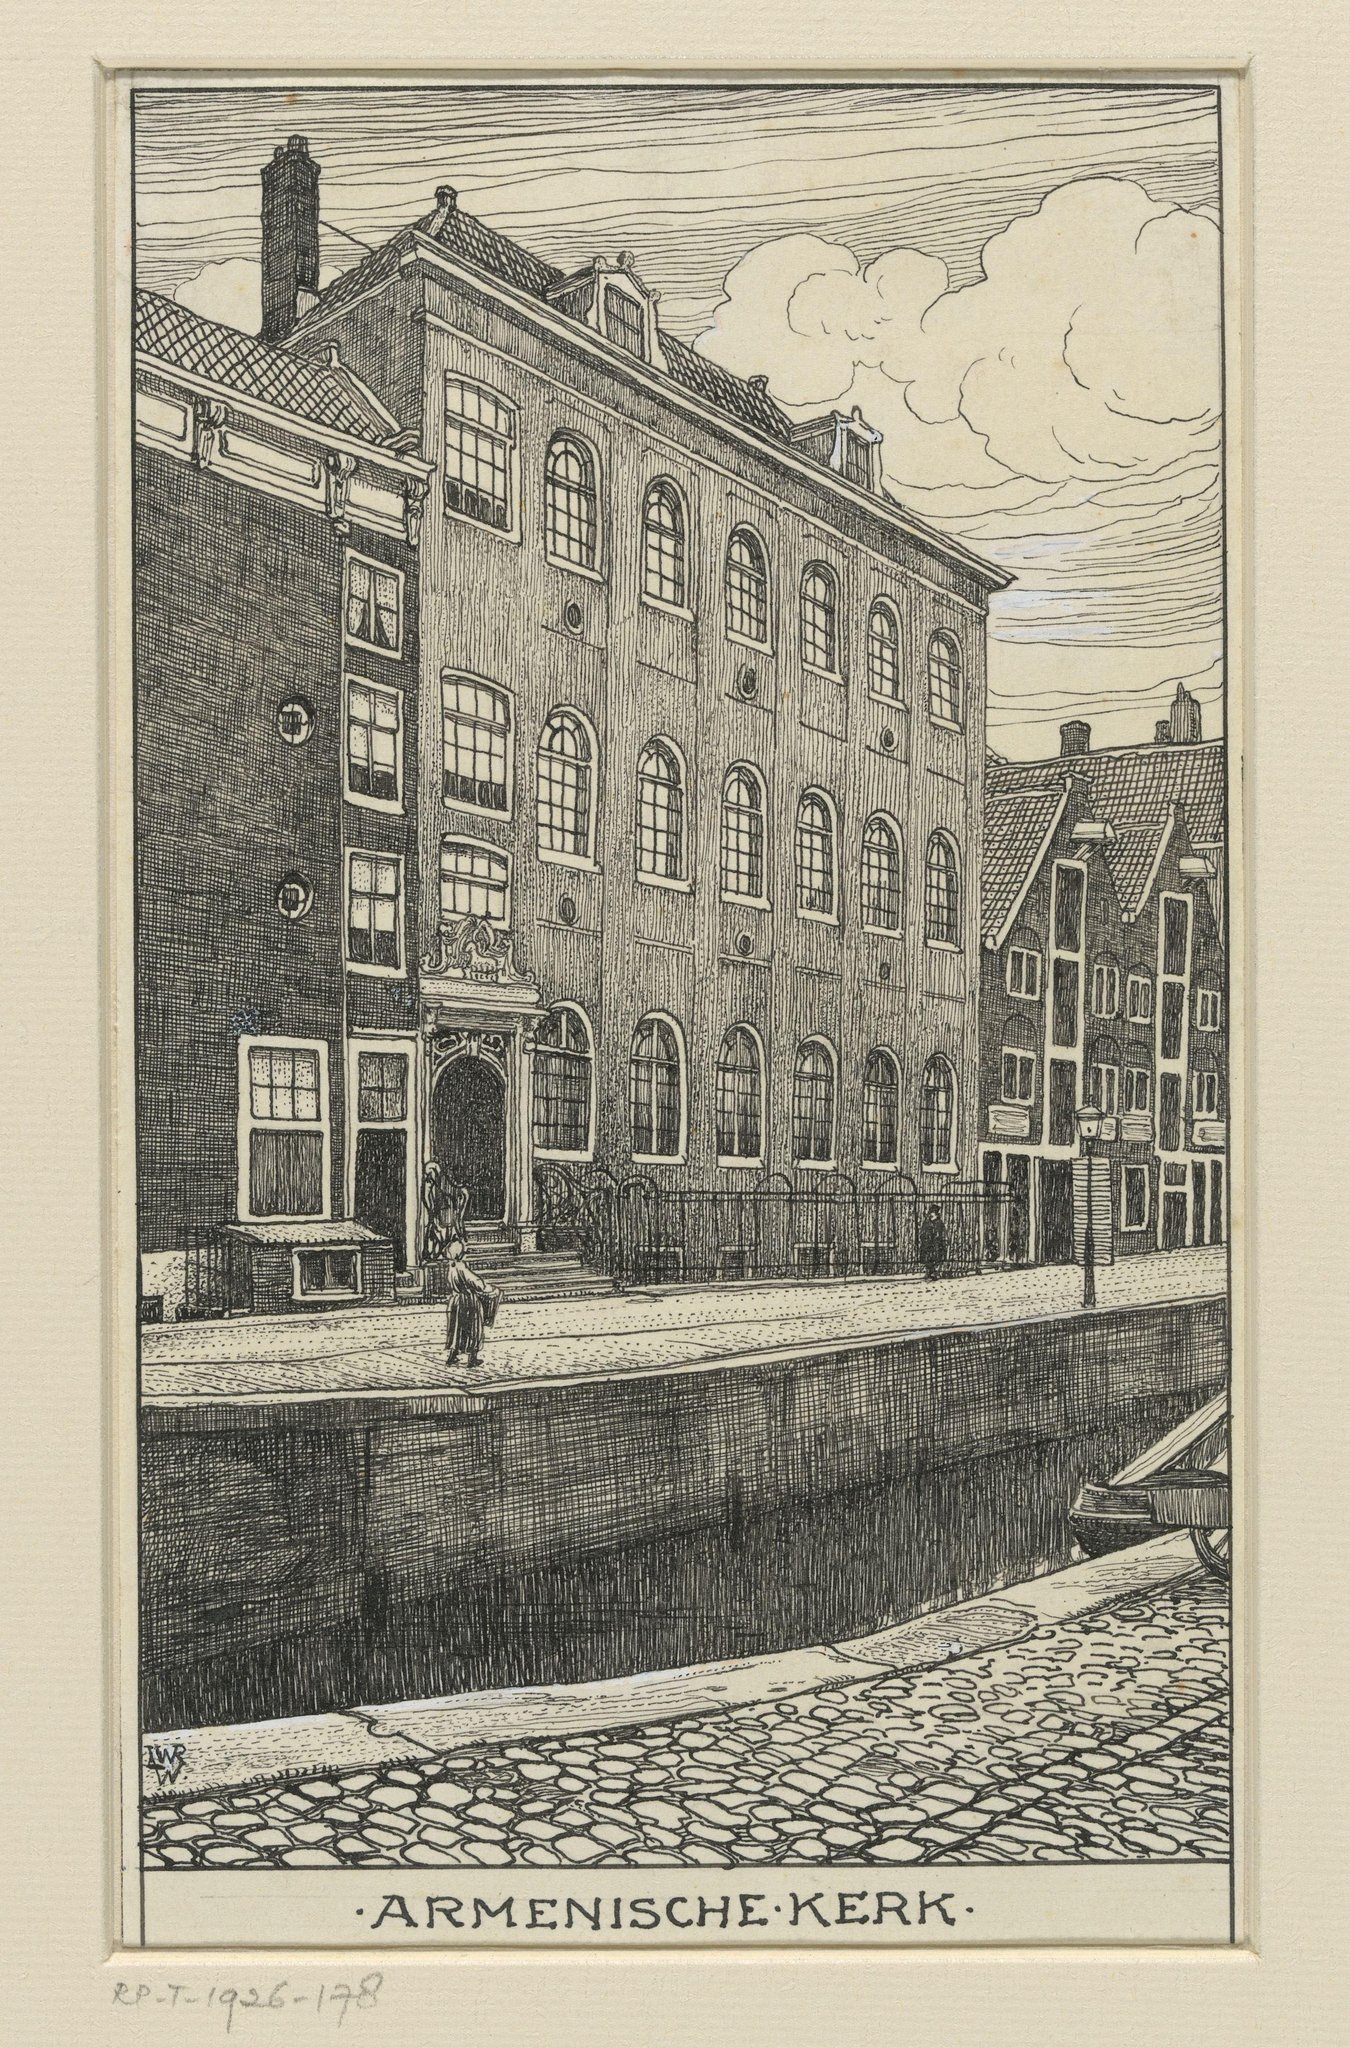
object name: drawing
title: De Armenische Kerk, Krom Boomssloot 22 te Amsterdam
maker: willem wenckebach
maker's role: designer, draughtsman, painter, print maker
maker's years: 1860-1937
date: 1870-1926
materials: paint, ink, paper, pencil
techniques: pen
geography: amsterdam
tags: church (exterior), amsterdam